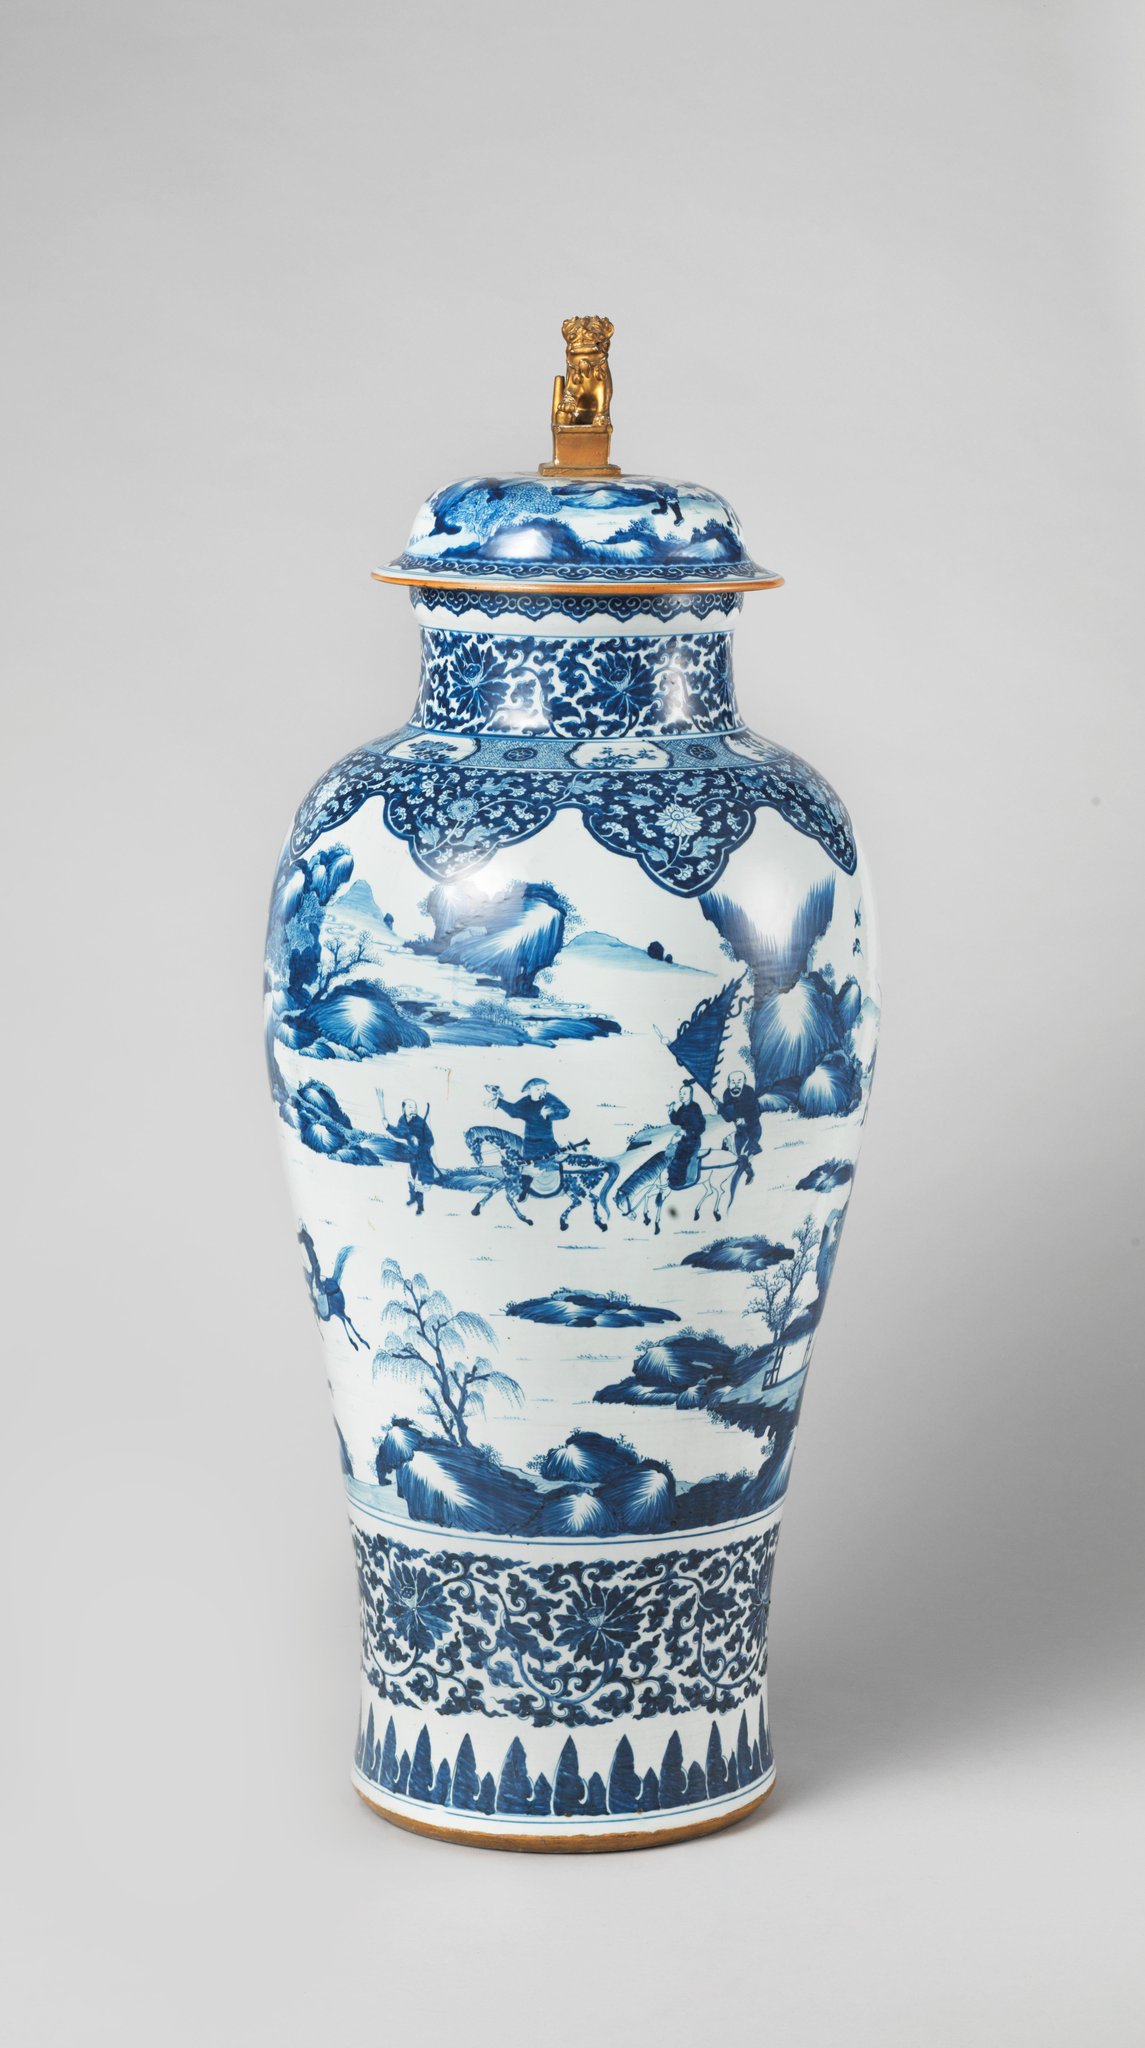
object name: dekselvaas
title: Baluster vase with a hunting scene and borders with floral scrolls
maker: Anonymous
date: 1700-1724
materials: cobalt, glaze, gold, paint, porcelain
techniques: firing, forming, gilding, turning, vitrification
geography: china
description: Deksel van porselein, beschilderd in onderglazuur blauw en op het glazuur goud. Op de wand een jachtscène met jagers te paard en te voet met wapens en honden in een landschap met bomen, bergen en rotsen. Hieronder een band met lotusranken. Dekselknop in de vorm van een shishi. Blauw-wit.